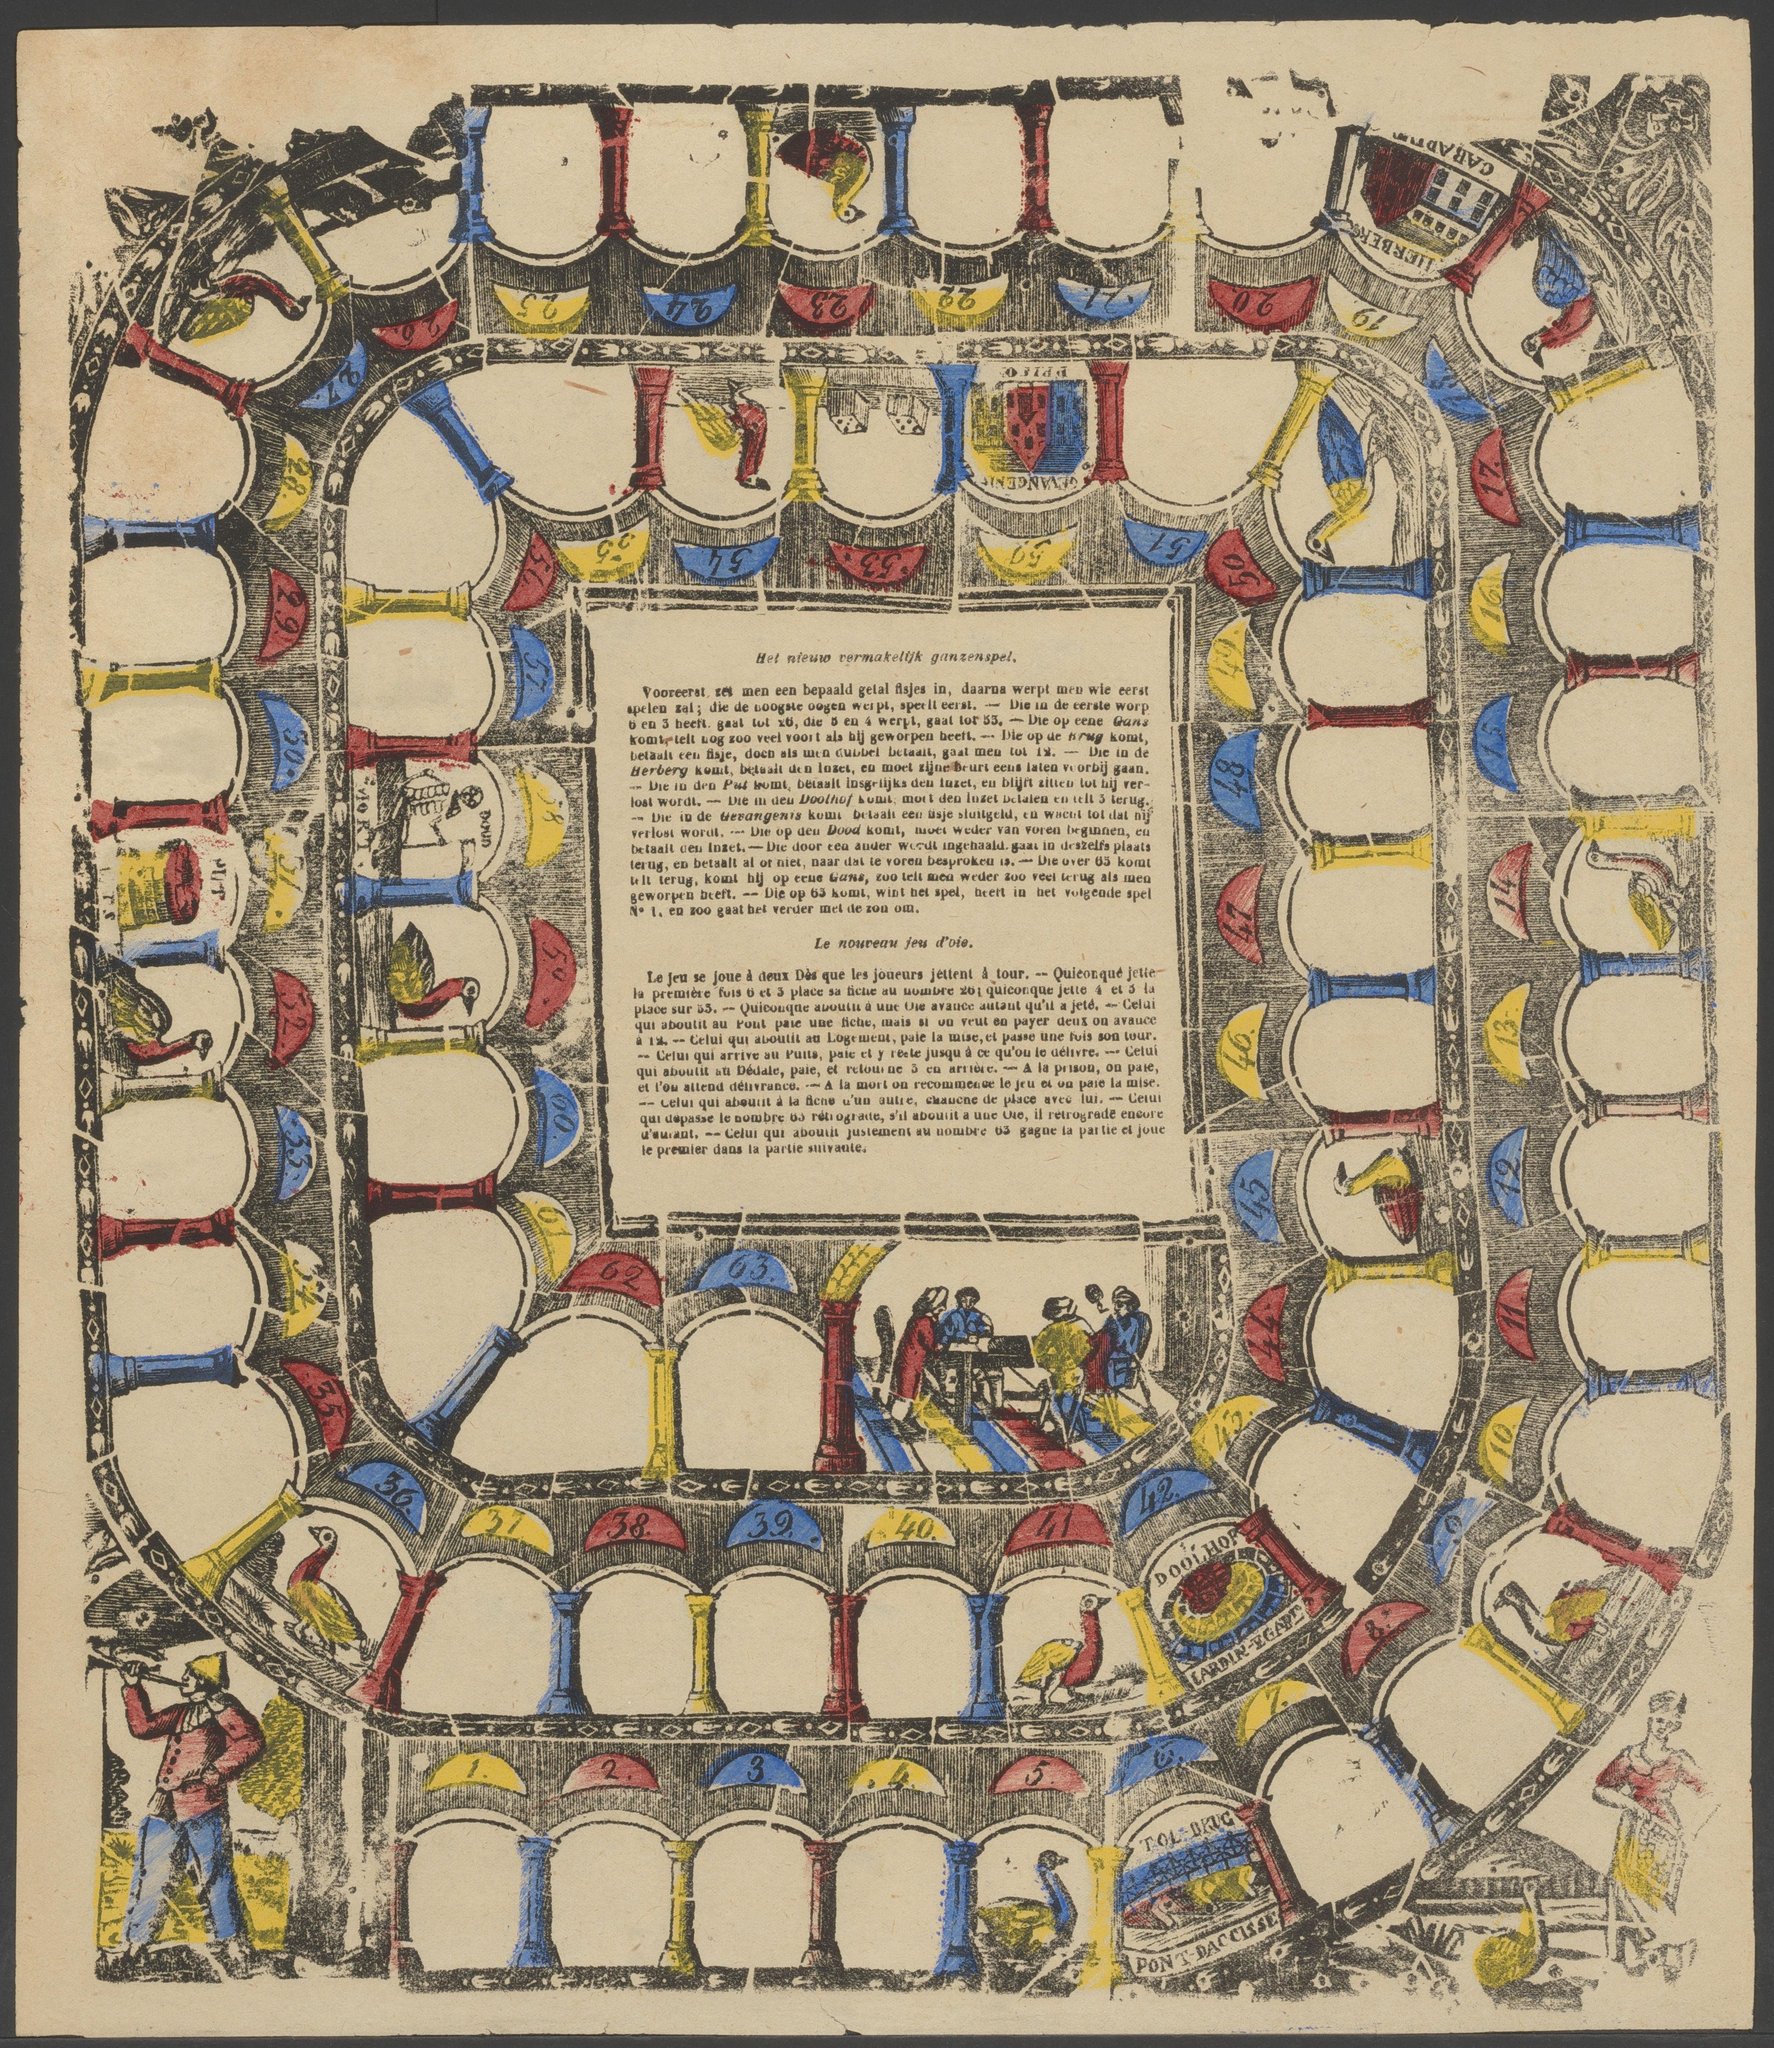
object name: gameboard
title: Ganzenbordspel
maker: Anonymous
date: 1833-1856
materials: paper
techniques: hand coloring, letterpress printing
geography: turnhout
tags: goose-game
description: Ganzenbordspel met een spiraal met vakken genummerd van 1 tot en met 63. In enkele vakken voorstellingen van ganzen. Op het middenveld de spelregels in boekdruk in het Nederlands en in het Frans. Onderwerpsrubrieken binnen de Atlas Zeden en Gewoonten: Zeden en gewoonten in engeren zin, Spel en vermaak, Gezelschapsspel II, Ganzenbord en dergelijke.